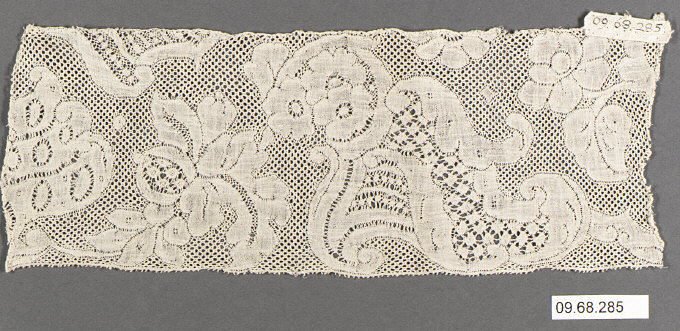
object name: fragment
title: Fragments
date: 1701-1800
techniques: lace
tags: flowers,leaves